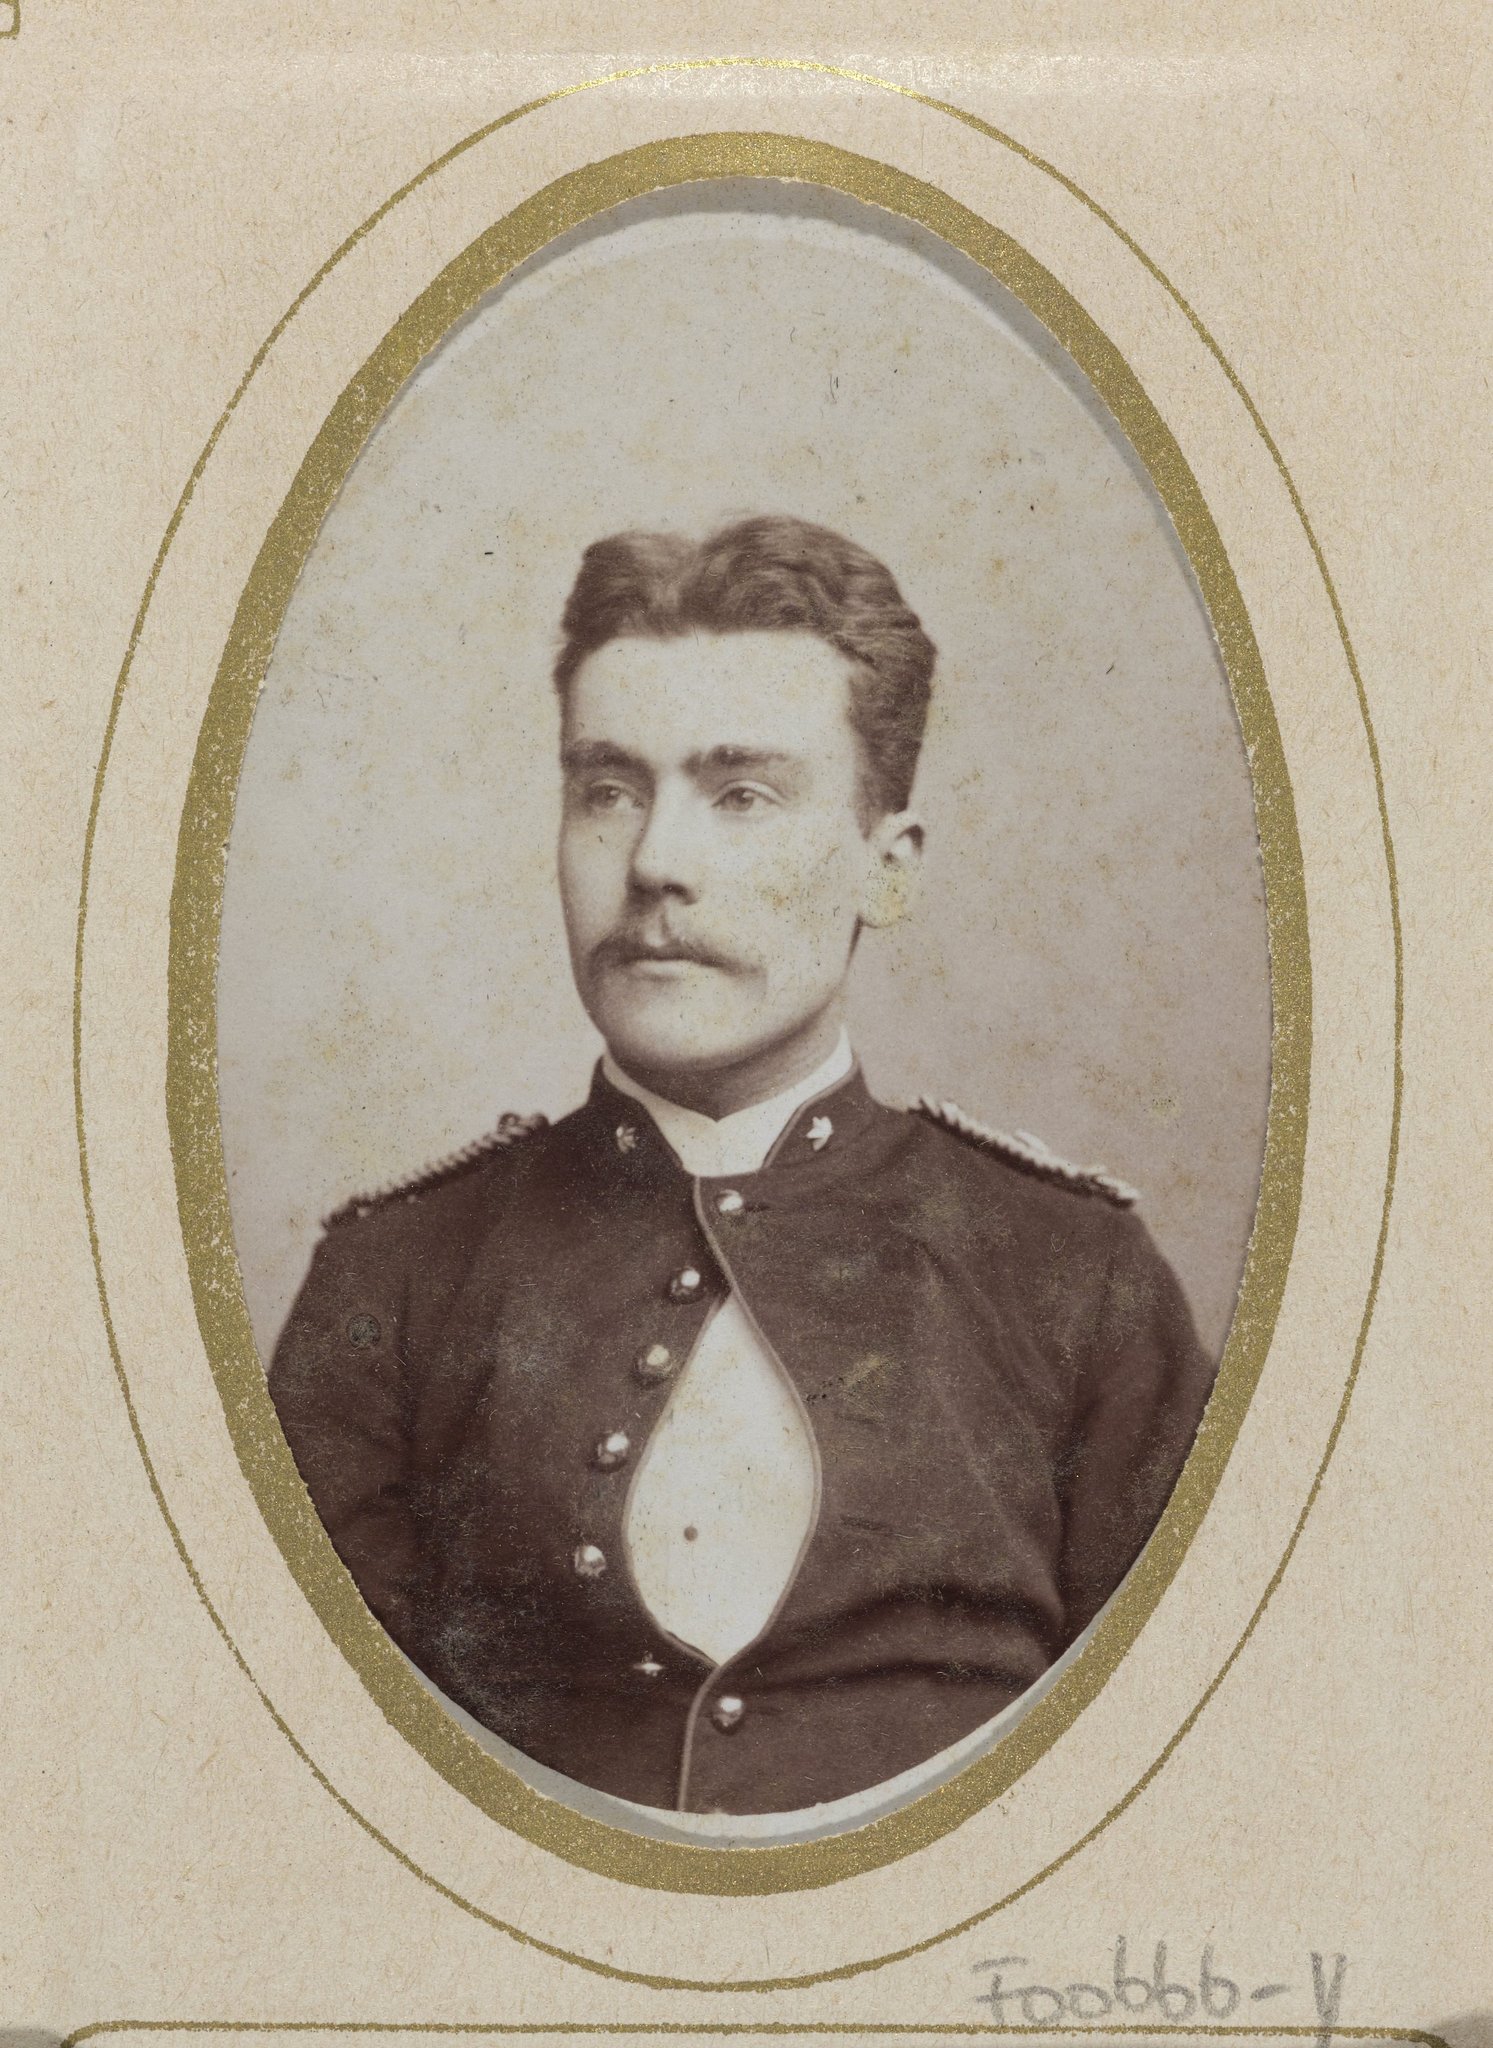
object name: carte de visite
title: Portret van een jonge man in uniform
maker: jan goedeljee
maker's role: fotograaf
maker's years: 1824-1905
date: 1860-1905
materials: cardboard, photographic support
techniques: albumen print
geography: leiden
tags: historical persons, (military) uniforms